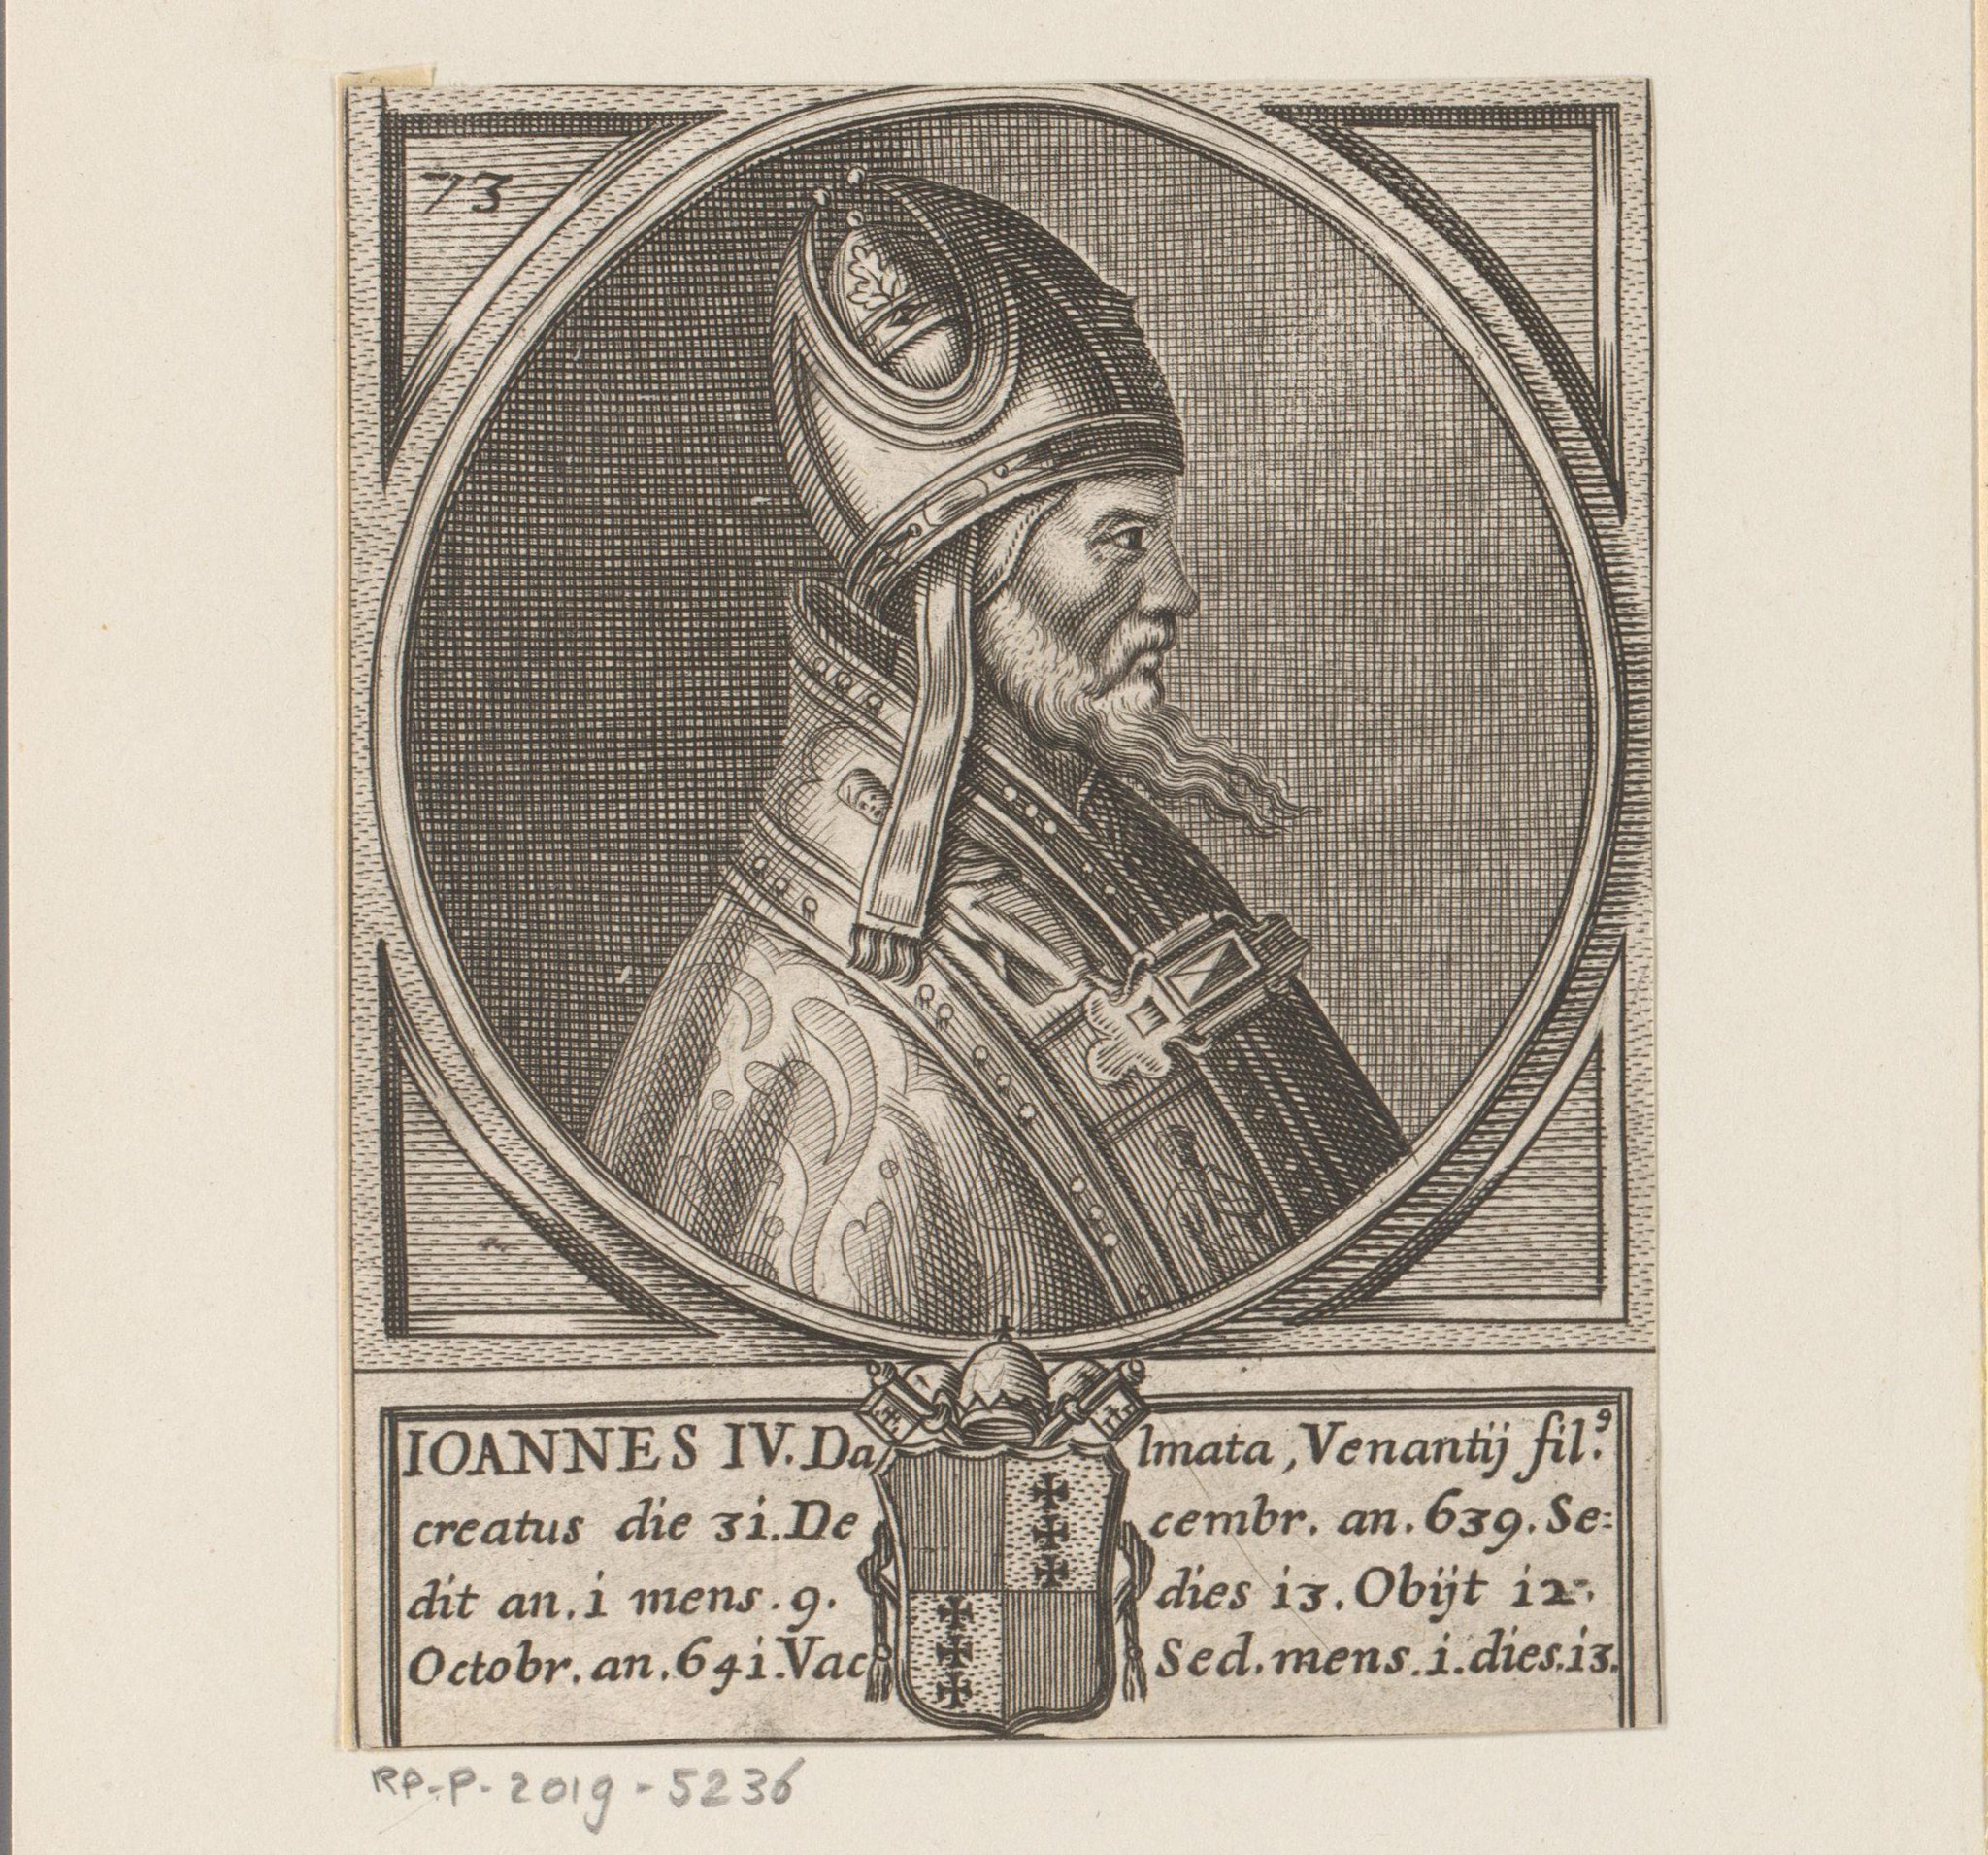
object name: print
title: Chronologia summorum Romanorum pontificum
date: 1675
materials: paper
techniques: engraving, etching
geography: rome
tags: rome, historical persons, pope, armorial bearing, heraldry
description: Portret afkomstig uit een grote prent, bestaande uit 17 bladen die samengevoegd konden worden, uitgegeven door Giovanni Giacomo de' Rossi in 1675.